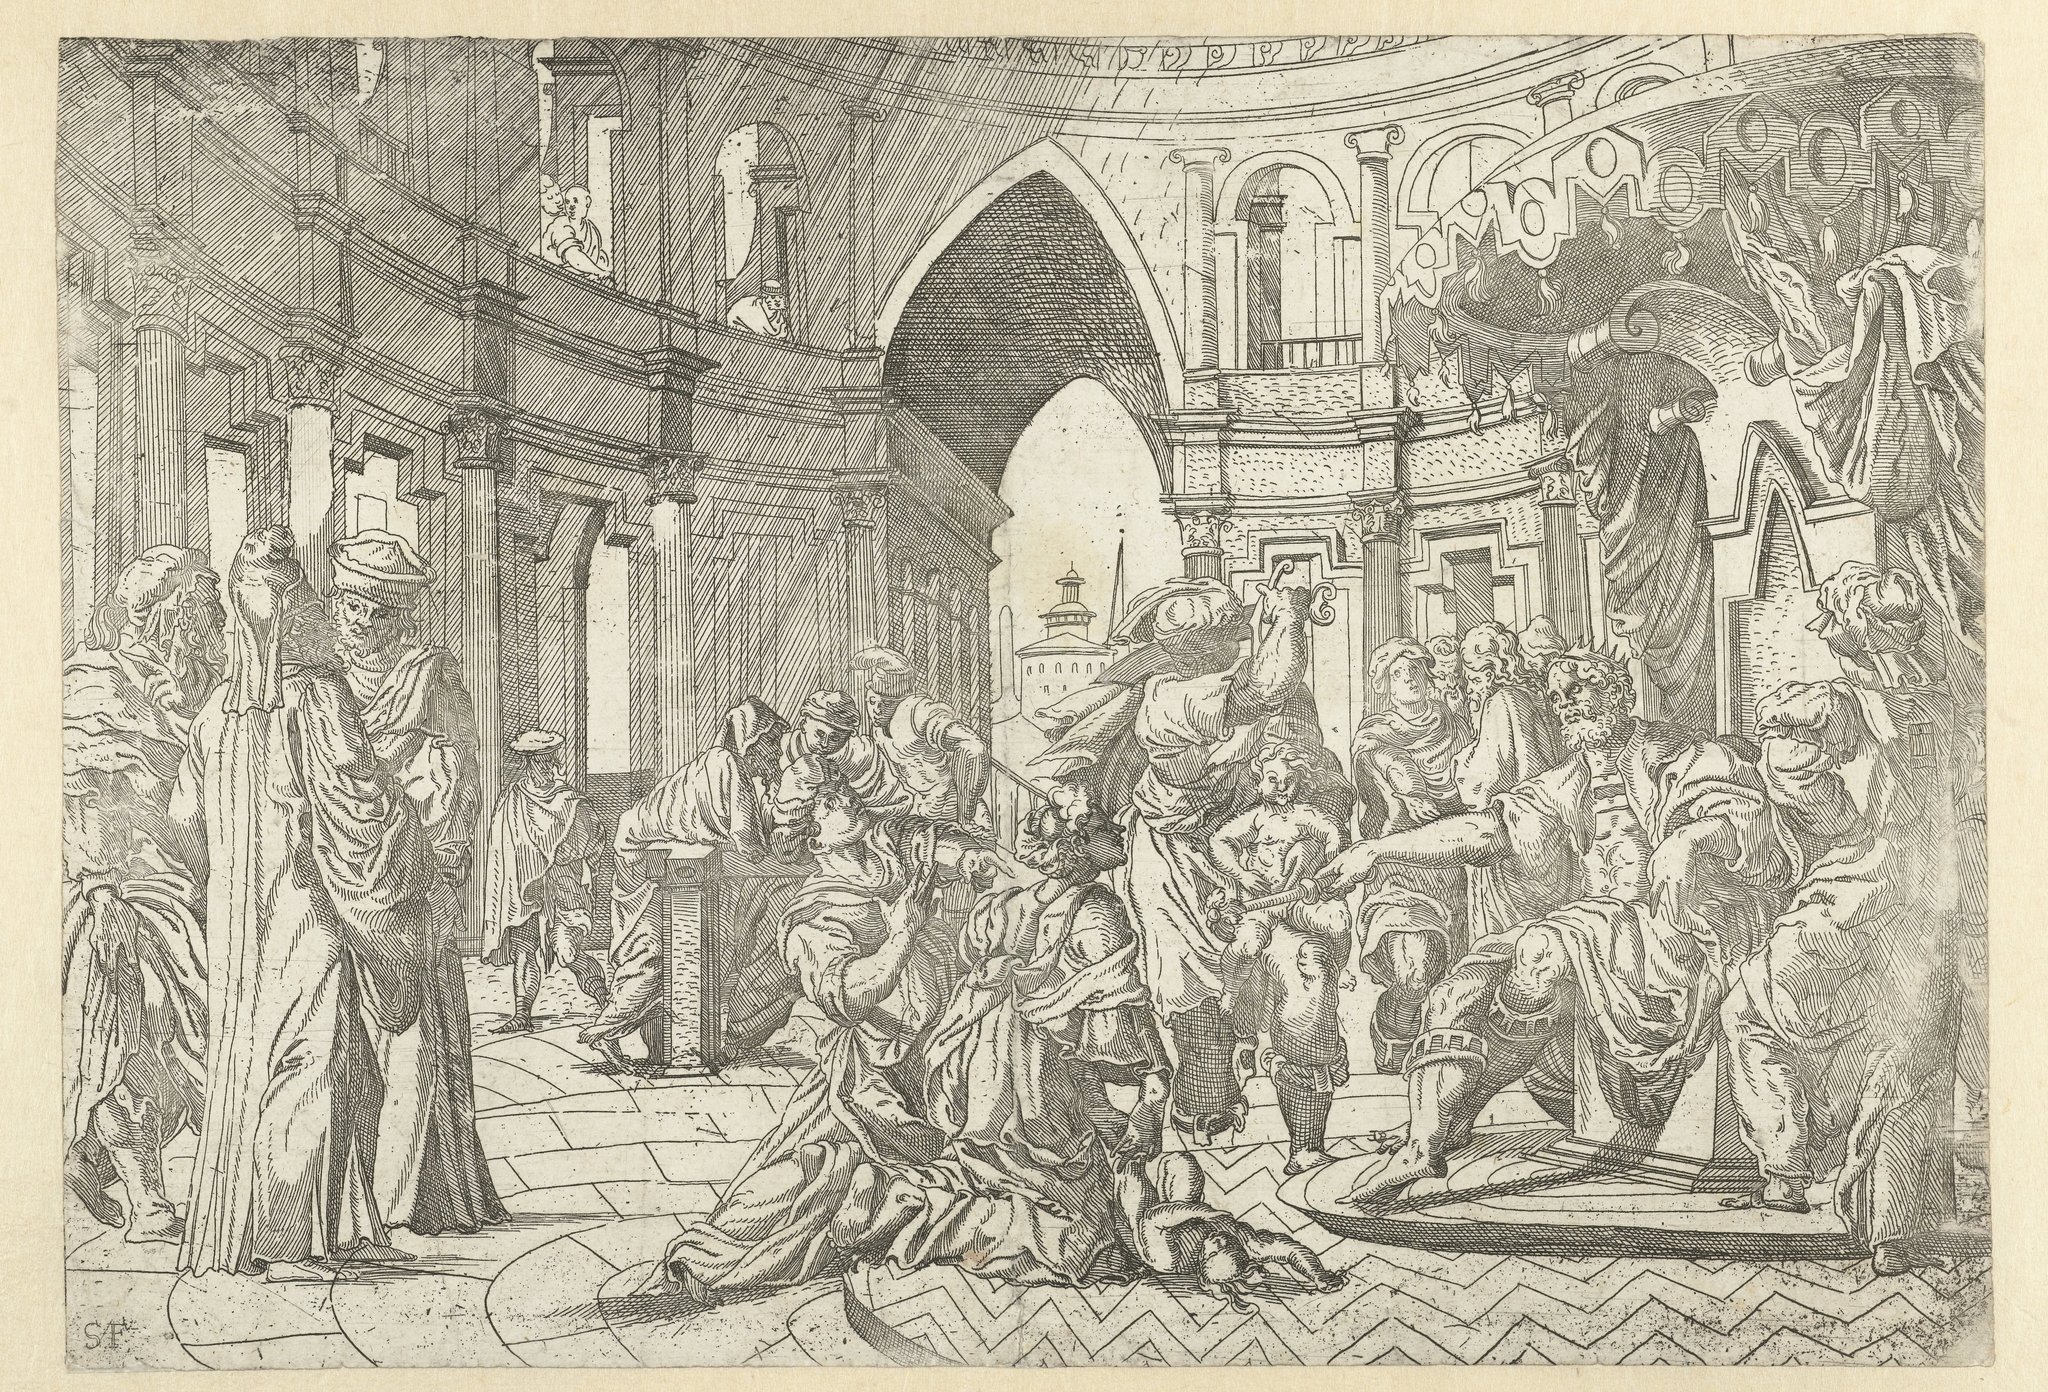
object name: print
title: Het oordeel van Salomo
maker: monogrammist saf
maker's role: print maker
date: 1530-1540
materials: paper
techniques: etching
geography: low countries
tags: solomon indicates the true mother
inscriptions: collector's mark: Lugt 2228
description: Binnen cirkelvormige ruimte met zuilen zit Salomo op troon en wijst met staf. Voor hem geknield twee moeders. De goede moeder wijst naar de slechte moeder die kind bij zich heeft. Beul met zwaard geheven houdt ander kind vast.